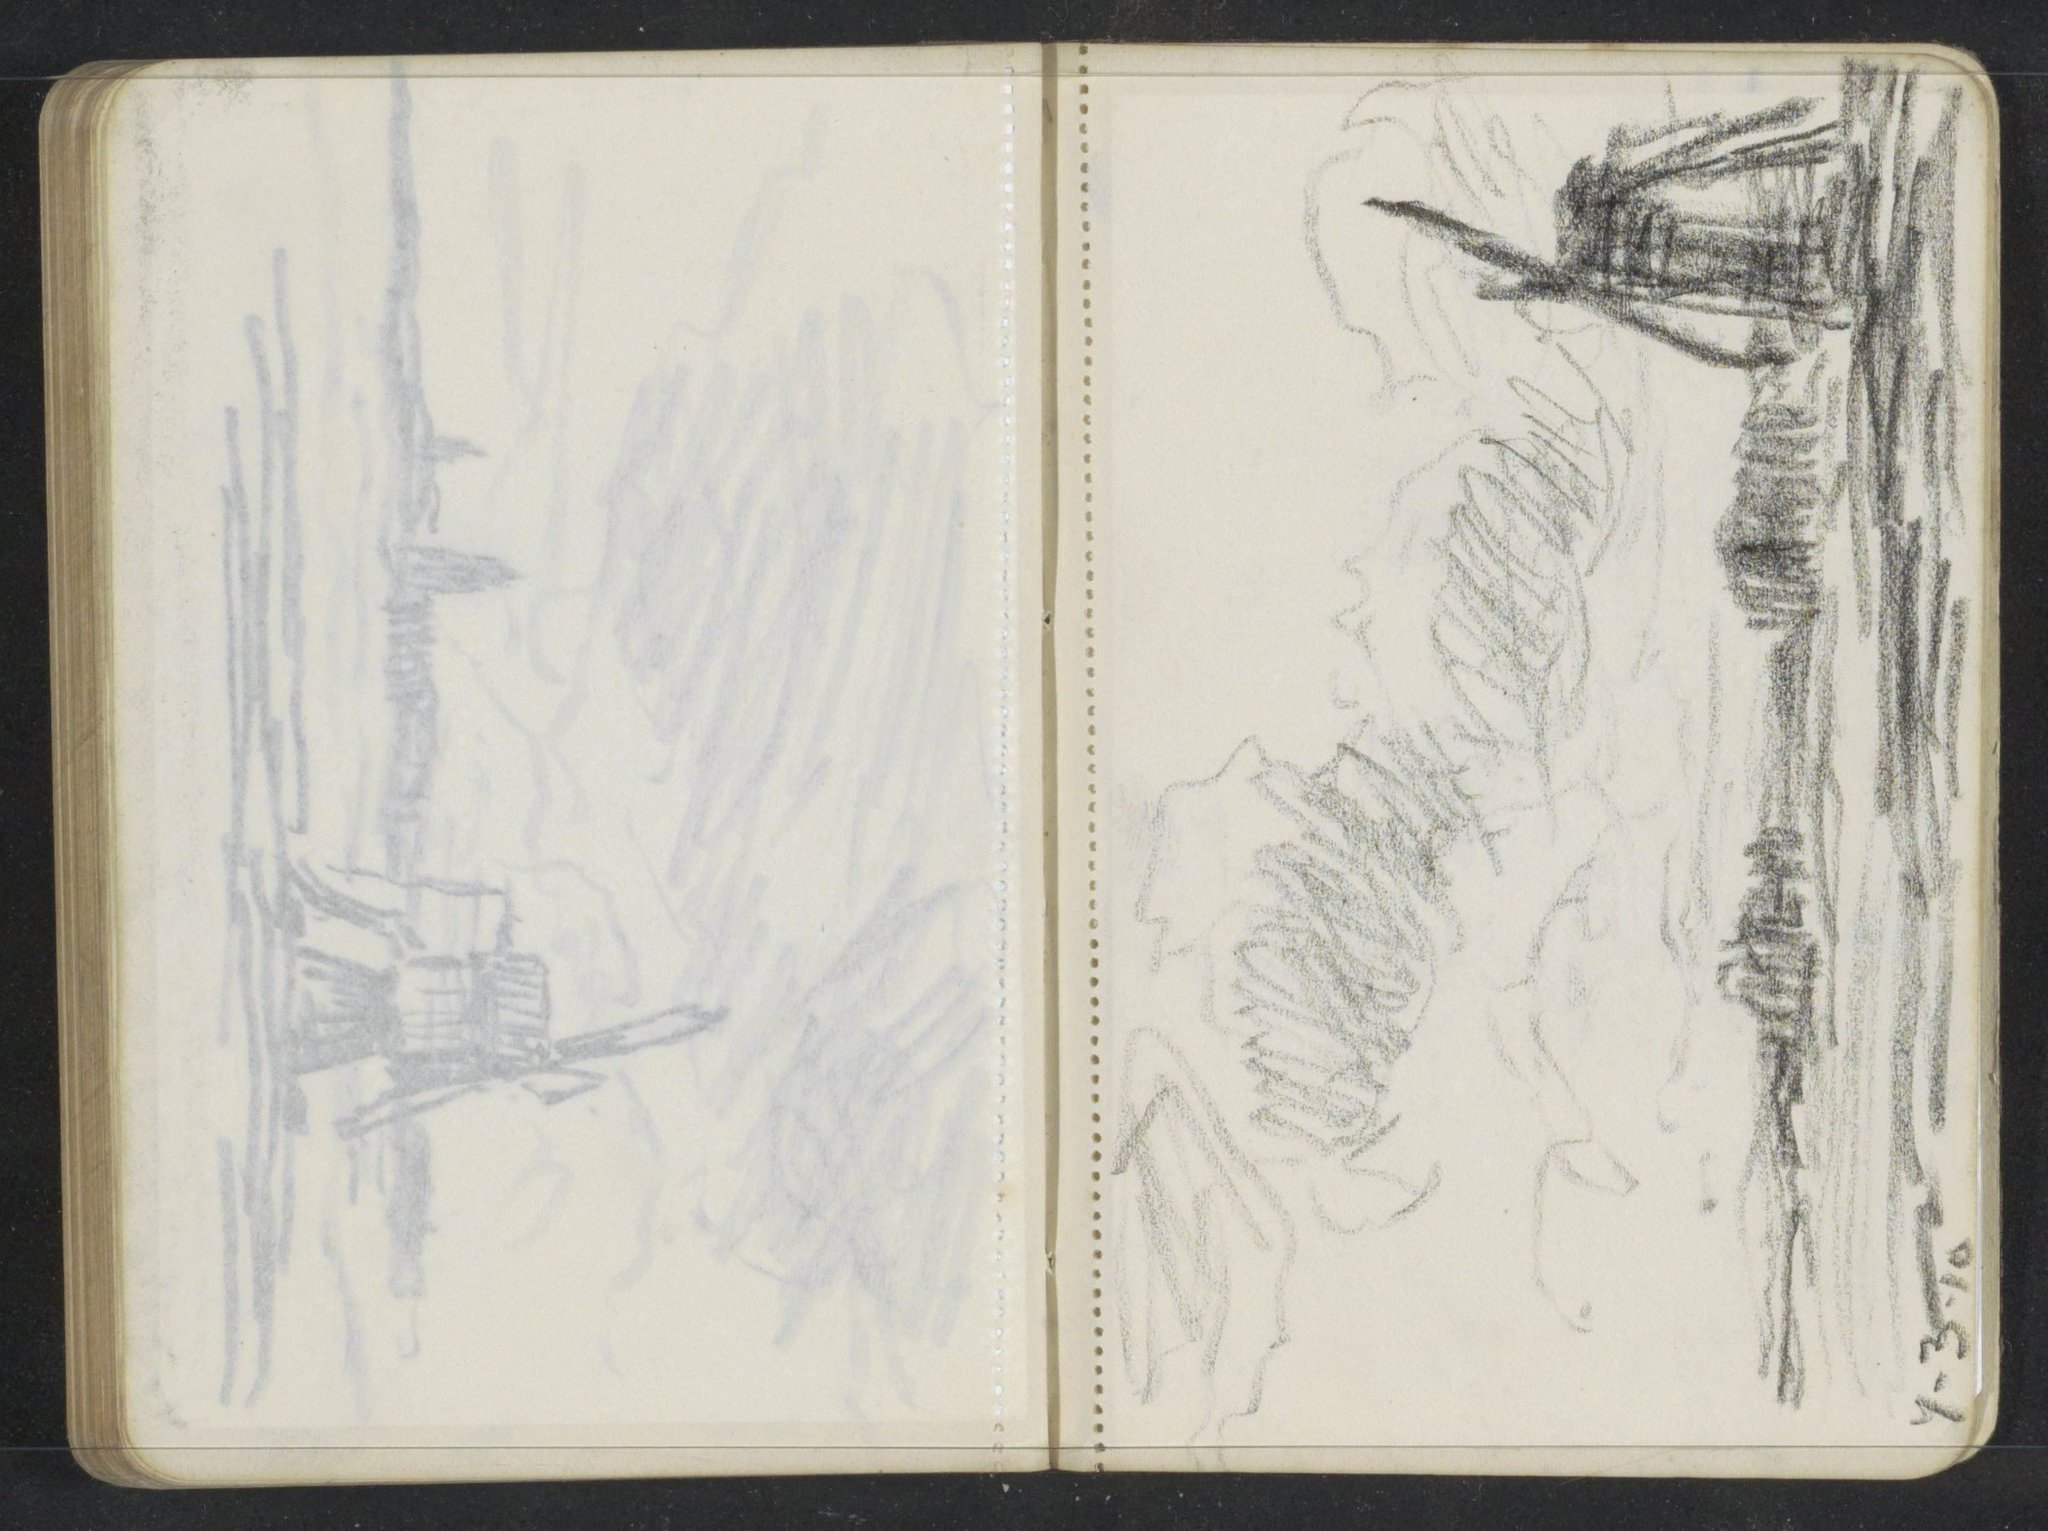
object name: sketchbook leaf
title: Molen in een landschap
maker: alexander shilling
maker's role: draughtsman, print maker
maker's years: 1859-1937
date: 1907-1910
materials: chalk, paper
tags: windmill in landscape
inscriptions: date: ‘7-3-10’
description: Blad 88 recto uit een schetsboek met 91 bladen.